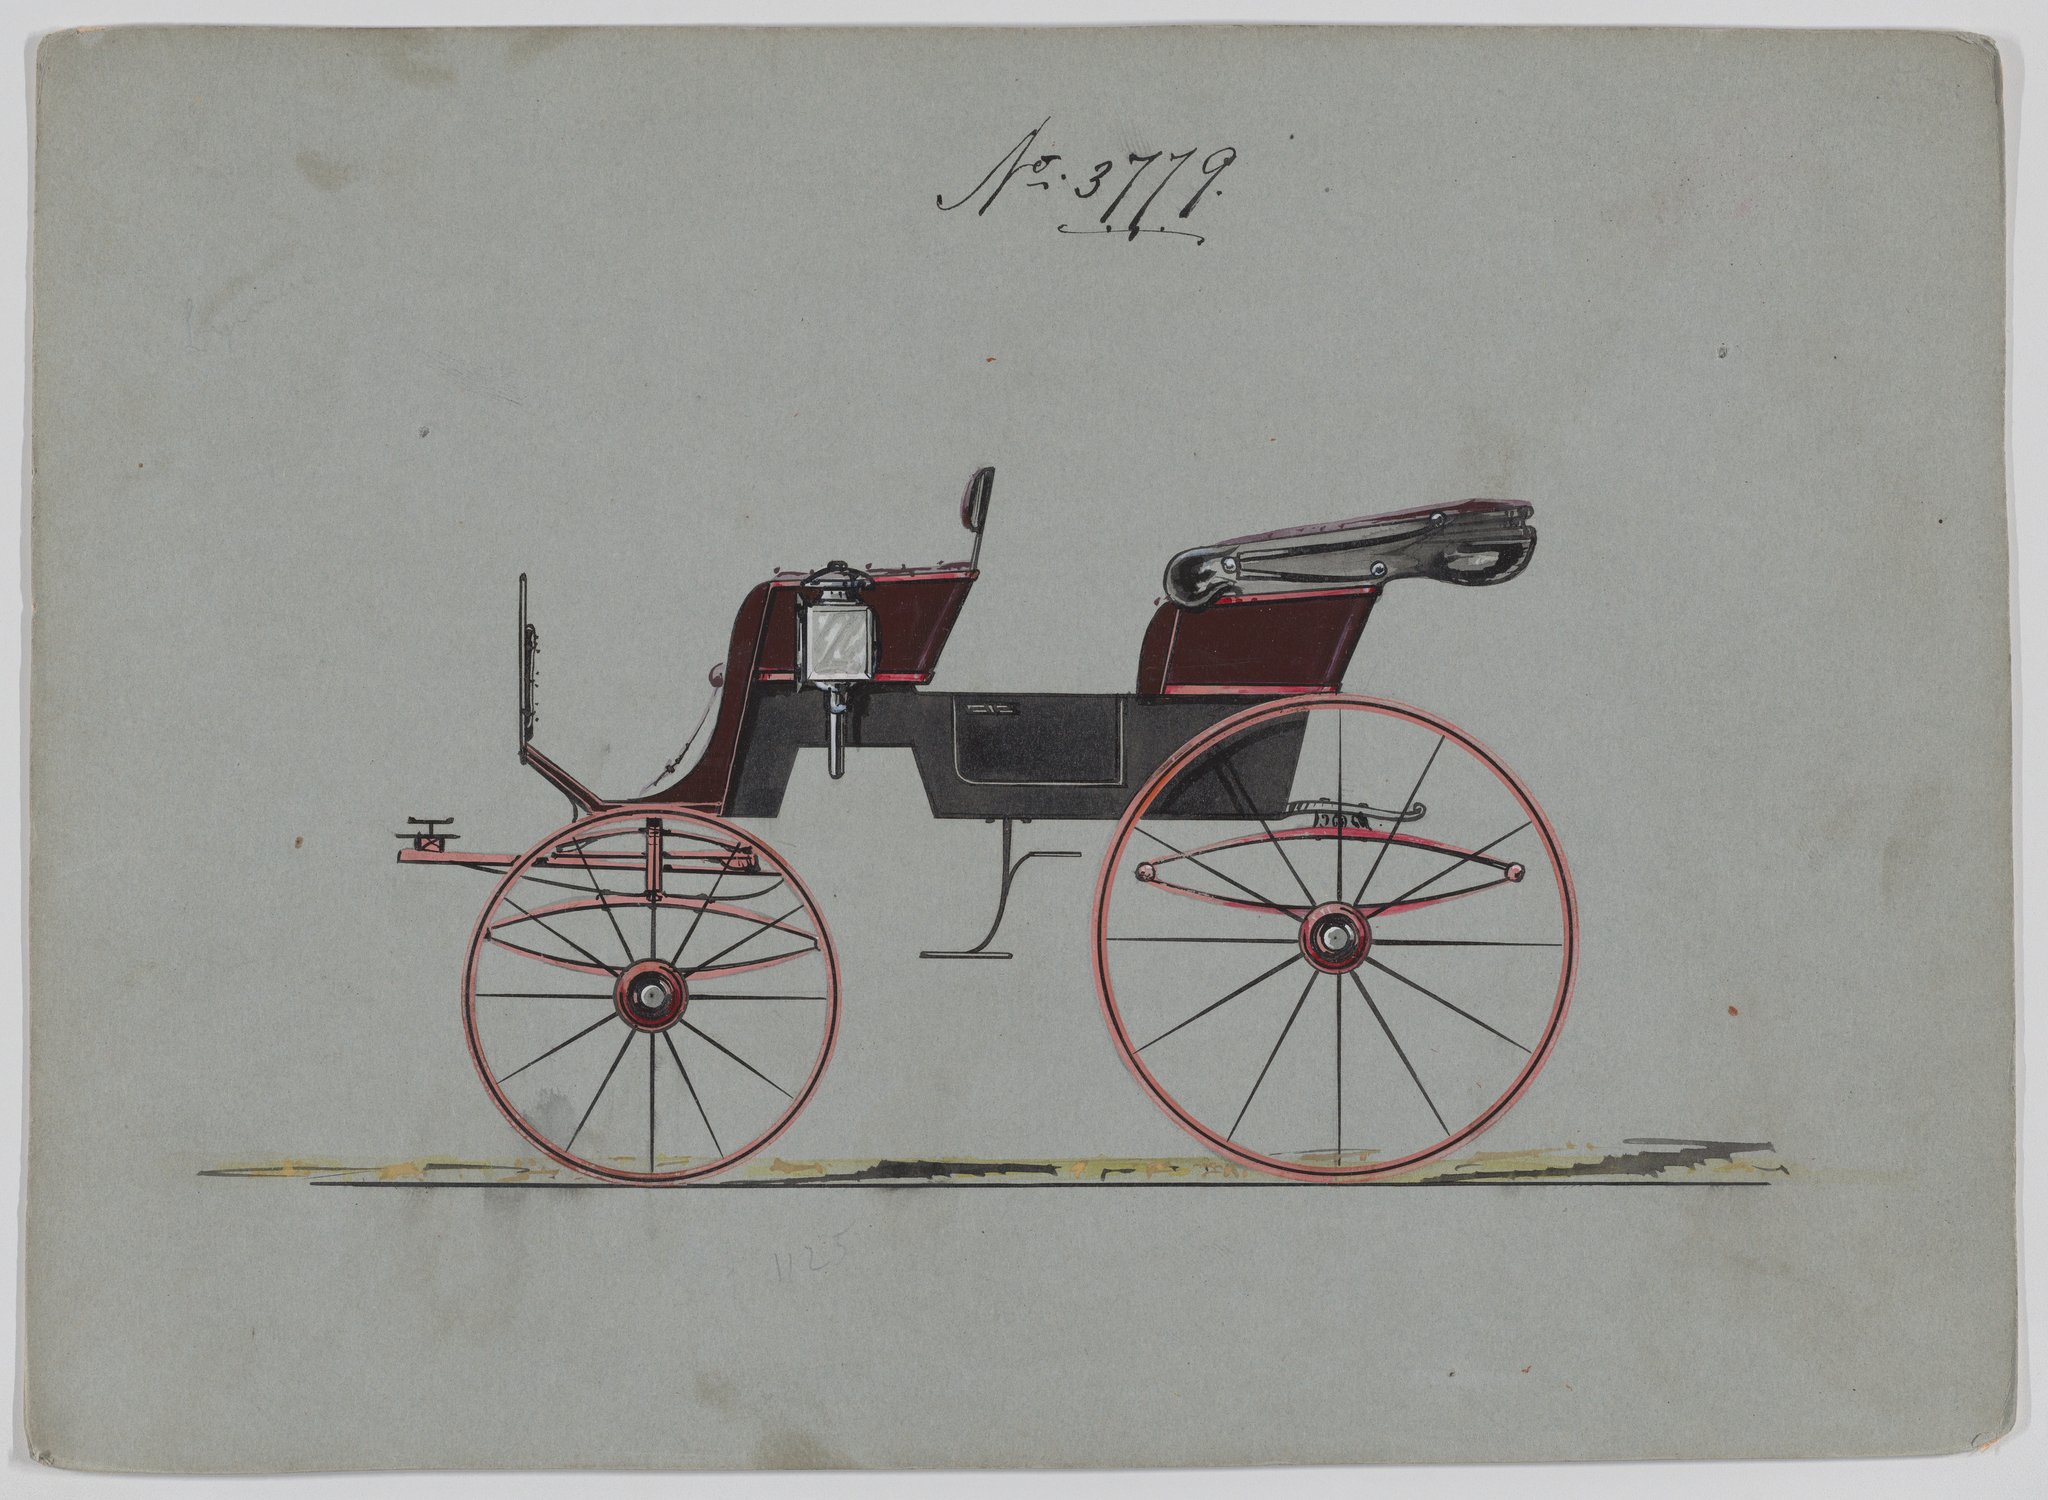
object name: drawing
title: Design for 2 seat Phaeton, no. 3779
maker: brewster & co.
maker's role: manufacturer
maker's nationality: american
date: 1882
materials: gouache, gum arabic, ink, watercolor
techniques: pen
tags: carriages